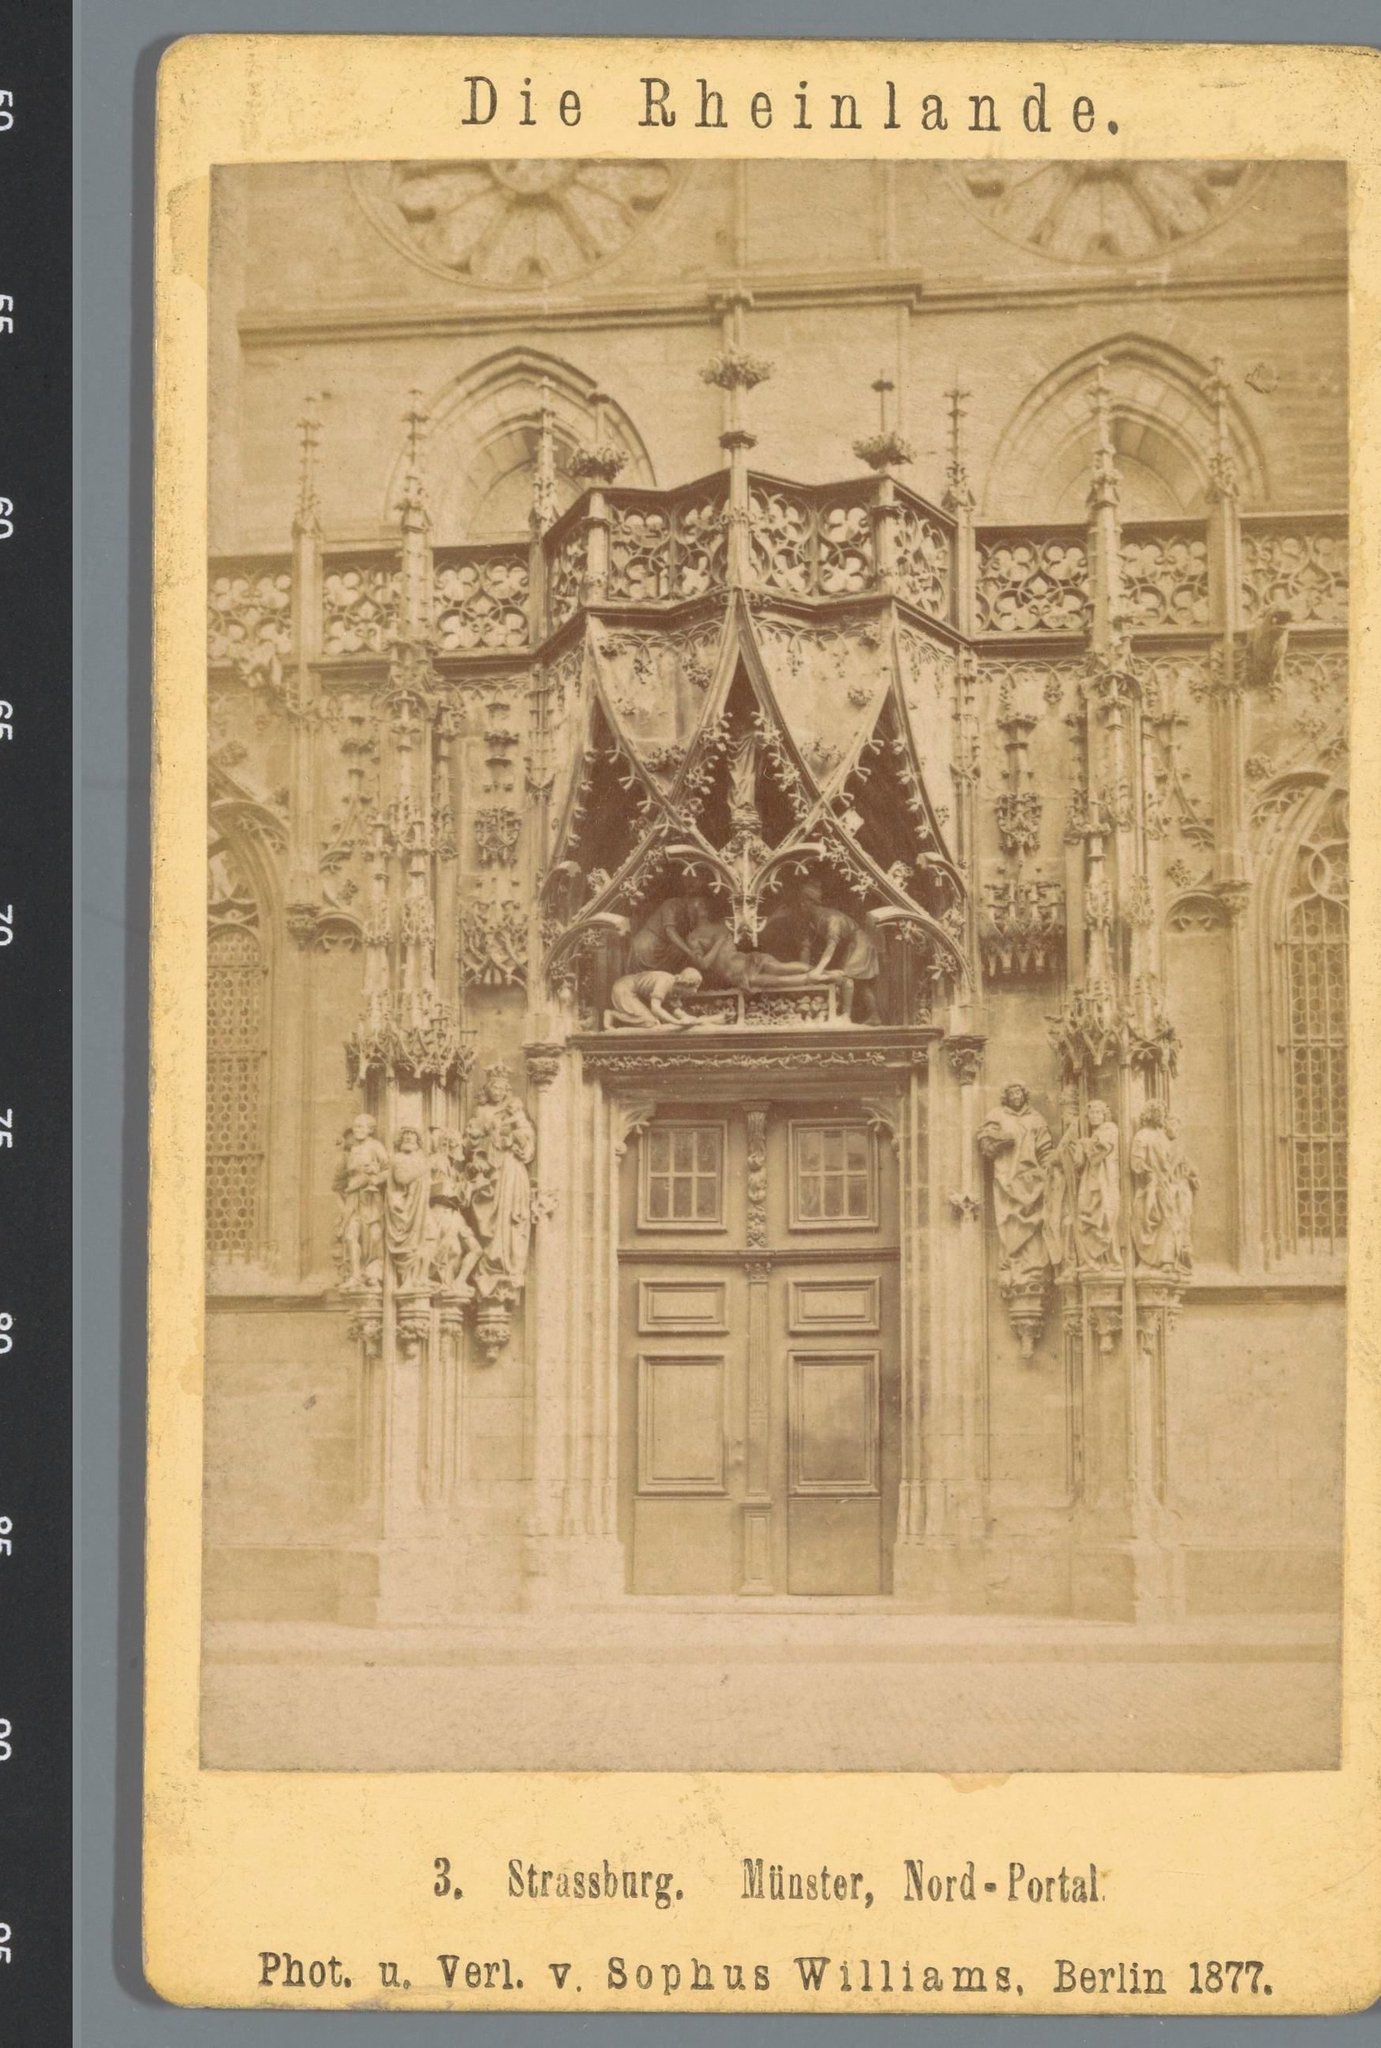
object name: carte de visite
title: Strassburg. Münster, Nord-Portal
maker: sophus williams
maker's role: publisher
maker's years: 1835-1900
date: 1877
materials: cardboard, paper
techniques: albumen print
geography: straatsburg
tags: parts of church exterior and annexes: portal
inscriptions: number: ‘3.’, number: ‘N 109.’